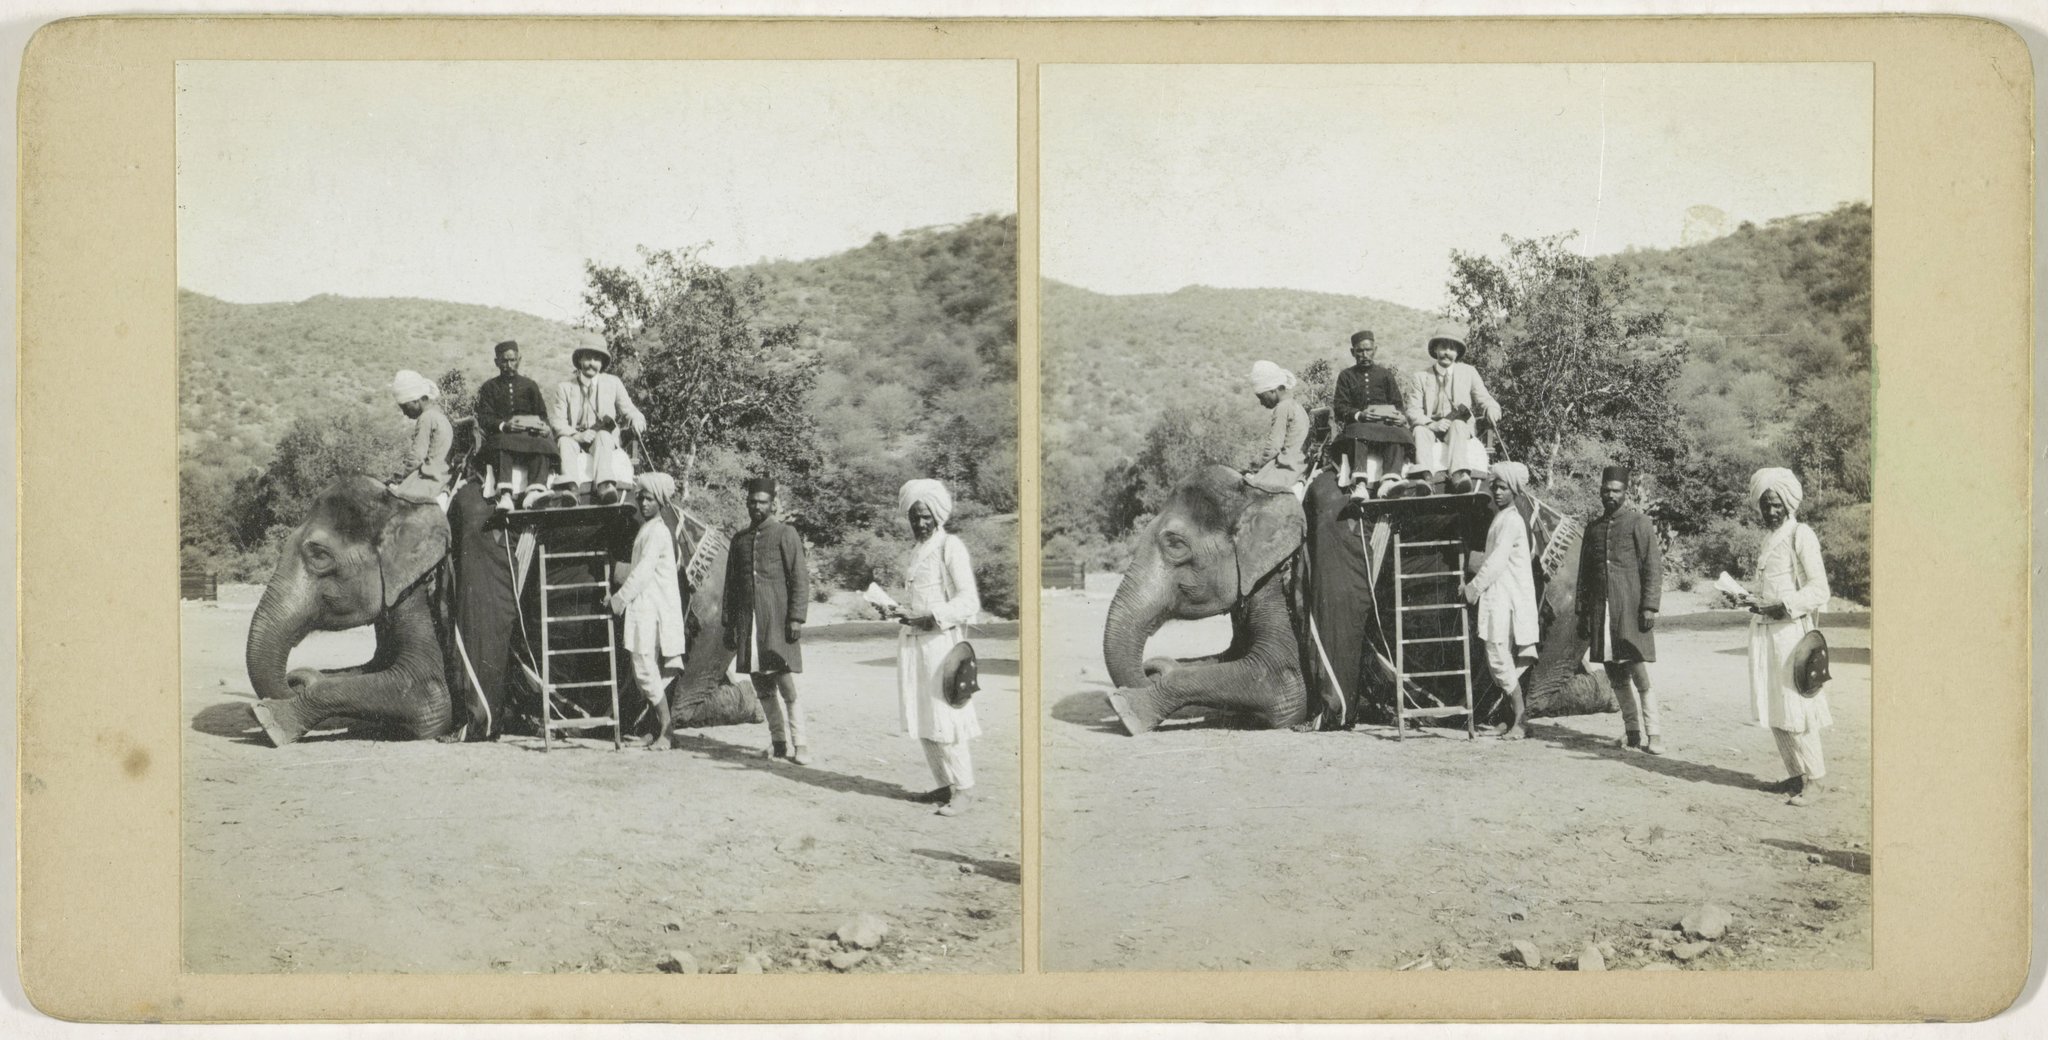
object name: stereograph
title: Reizigers met olifant onderweg naar Ajmer, India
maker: Anonymous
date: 1900-1920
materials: paper, cardboard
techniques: gelatin silver print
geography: ajmer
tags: trunked animals: elephant